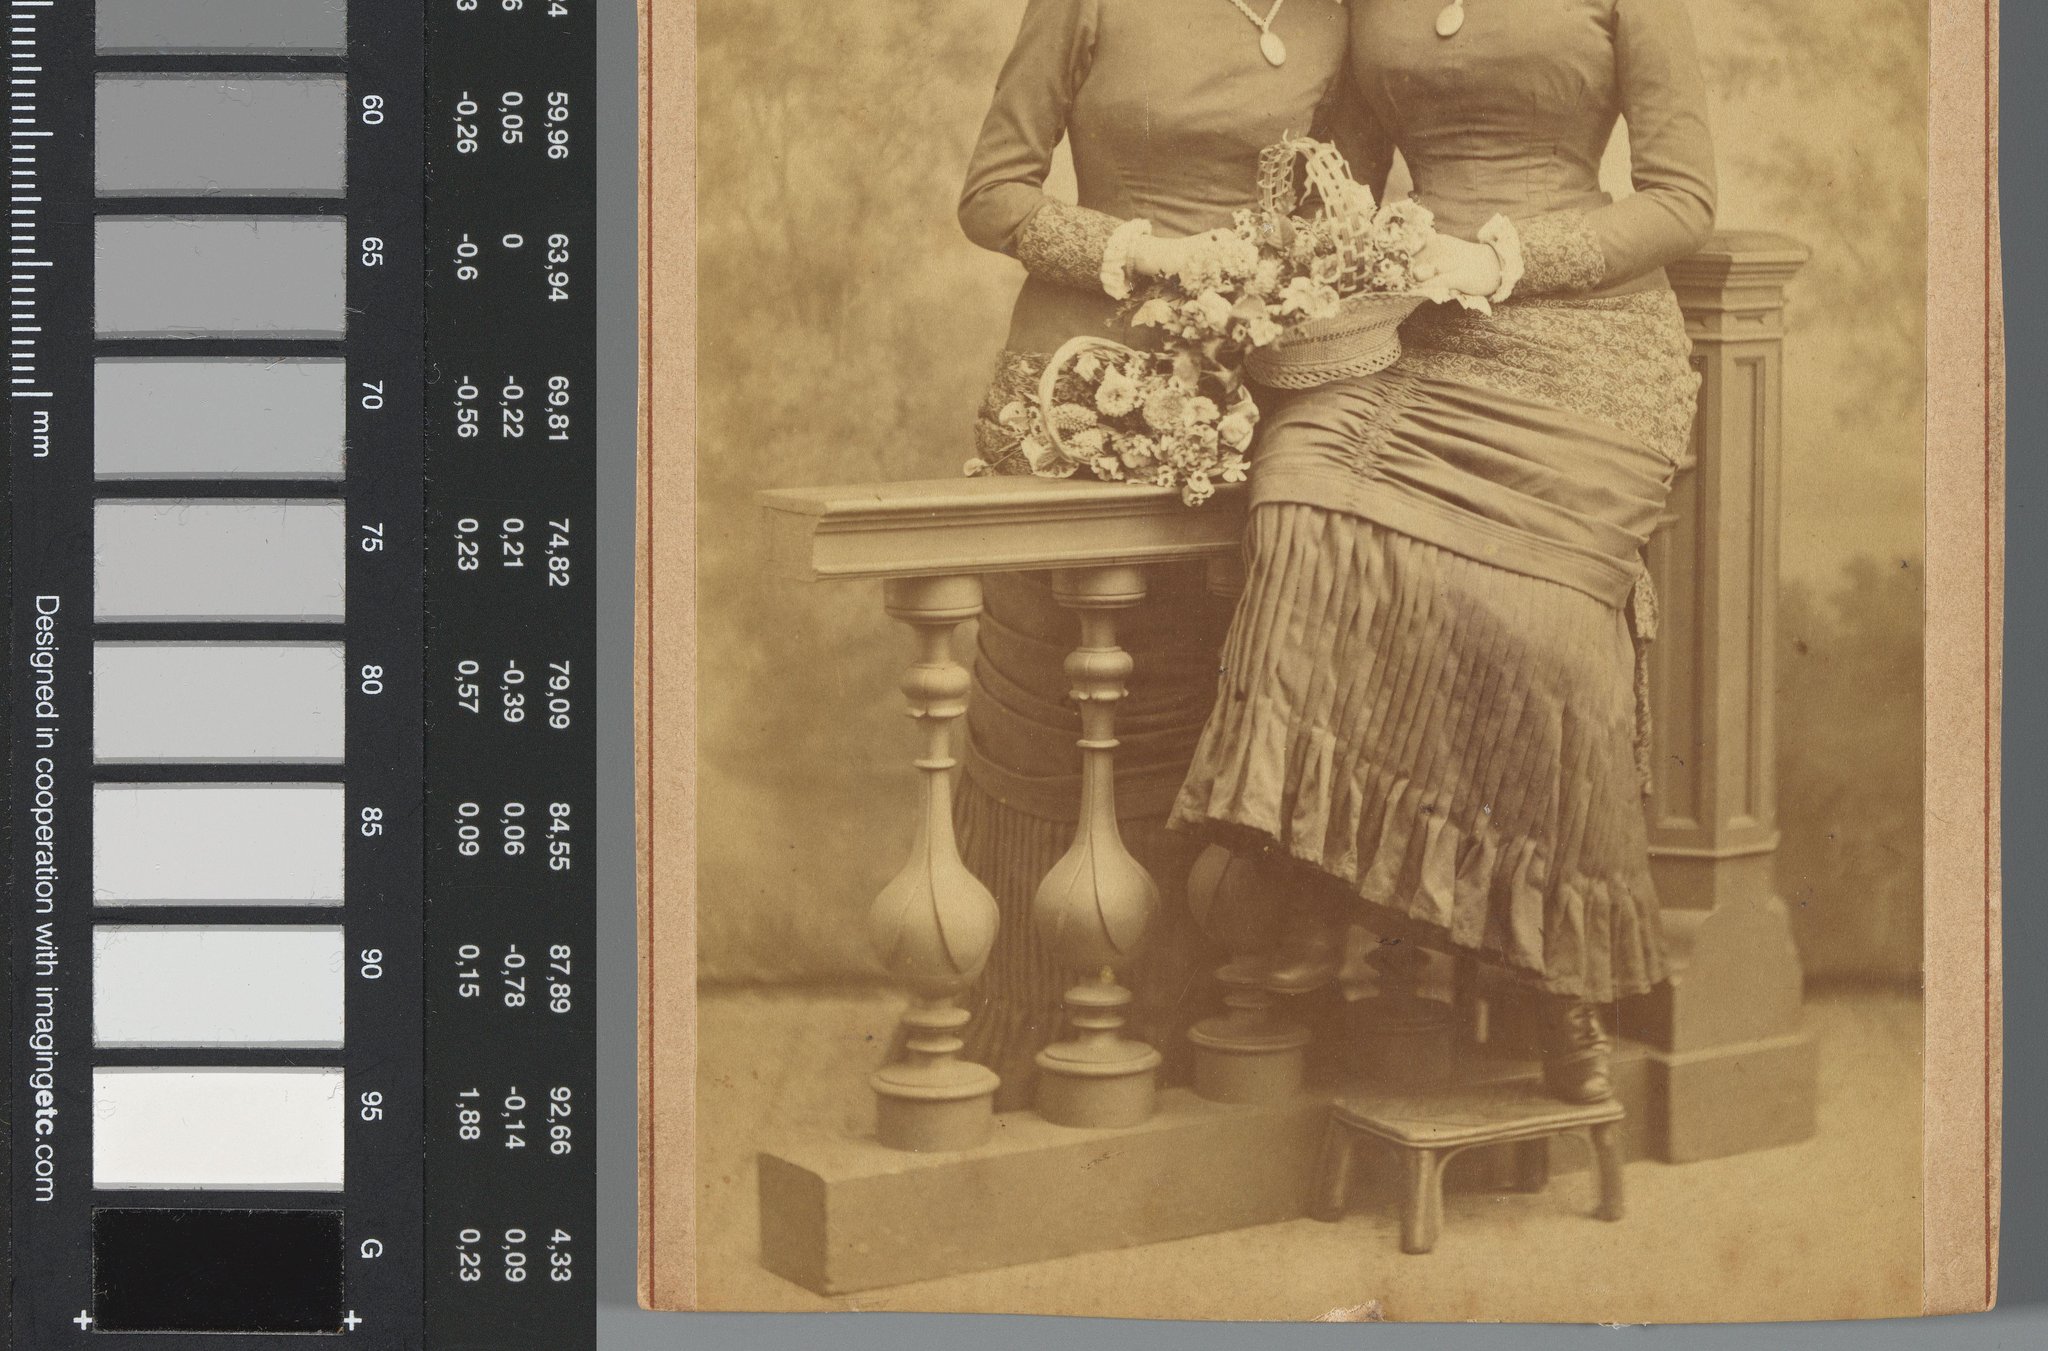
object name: cabinet photograph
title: Studioportret van Pauline en Emilie van den Berg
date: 1880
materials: cardboard, photographic support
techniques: albumen print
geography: the hague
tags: batavia, emilie albertine onnen-van den berg, the hague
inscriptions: name: ‘DE LAVIETER & Co LA HAYE.’, name: ‘DE LAVIETER & Co / PHOTOGRAPHES DE S. M. LE ROI, / ET DE SON ALTESSE ROYALE / LE PRINCE ALEXANDRE / DES PAYS-BAS. / LA HAYE.’, inscription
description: Twee jonge vrouwen met bloemenmandjes bij een balustrade; de kabinetfoto is afgesneden aan zowel de boven- als onderzijde.